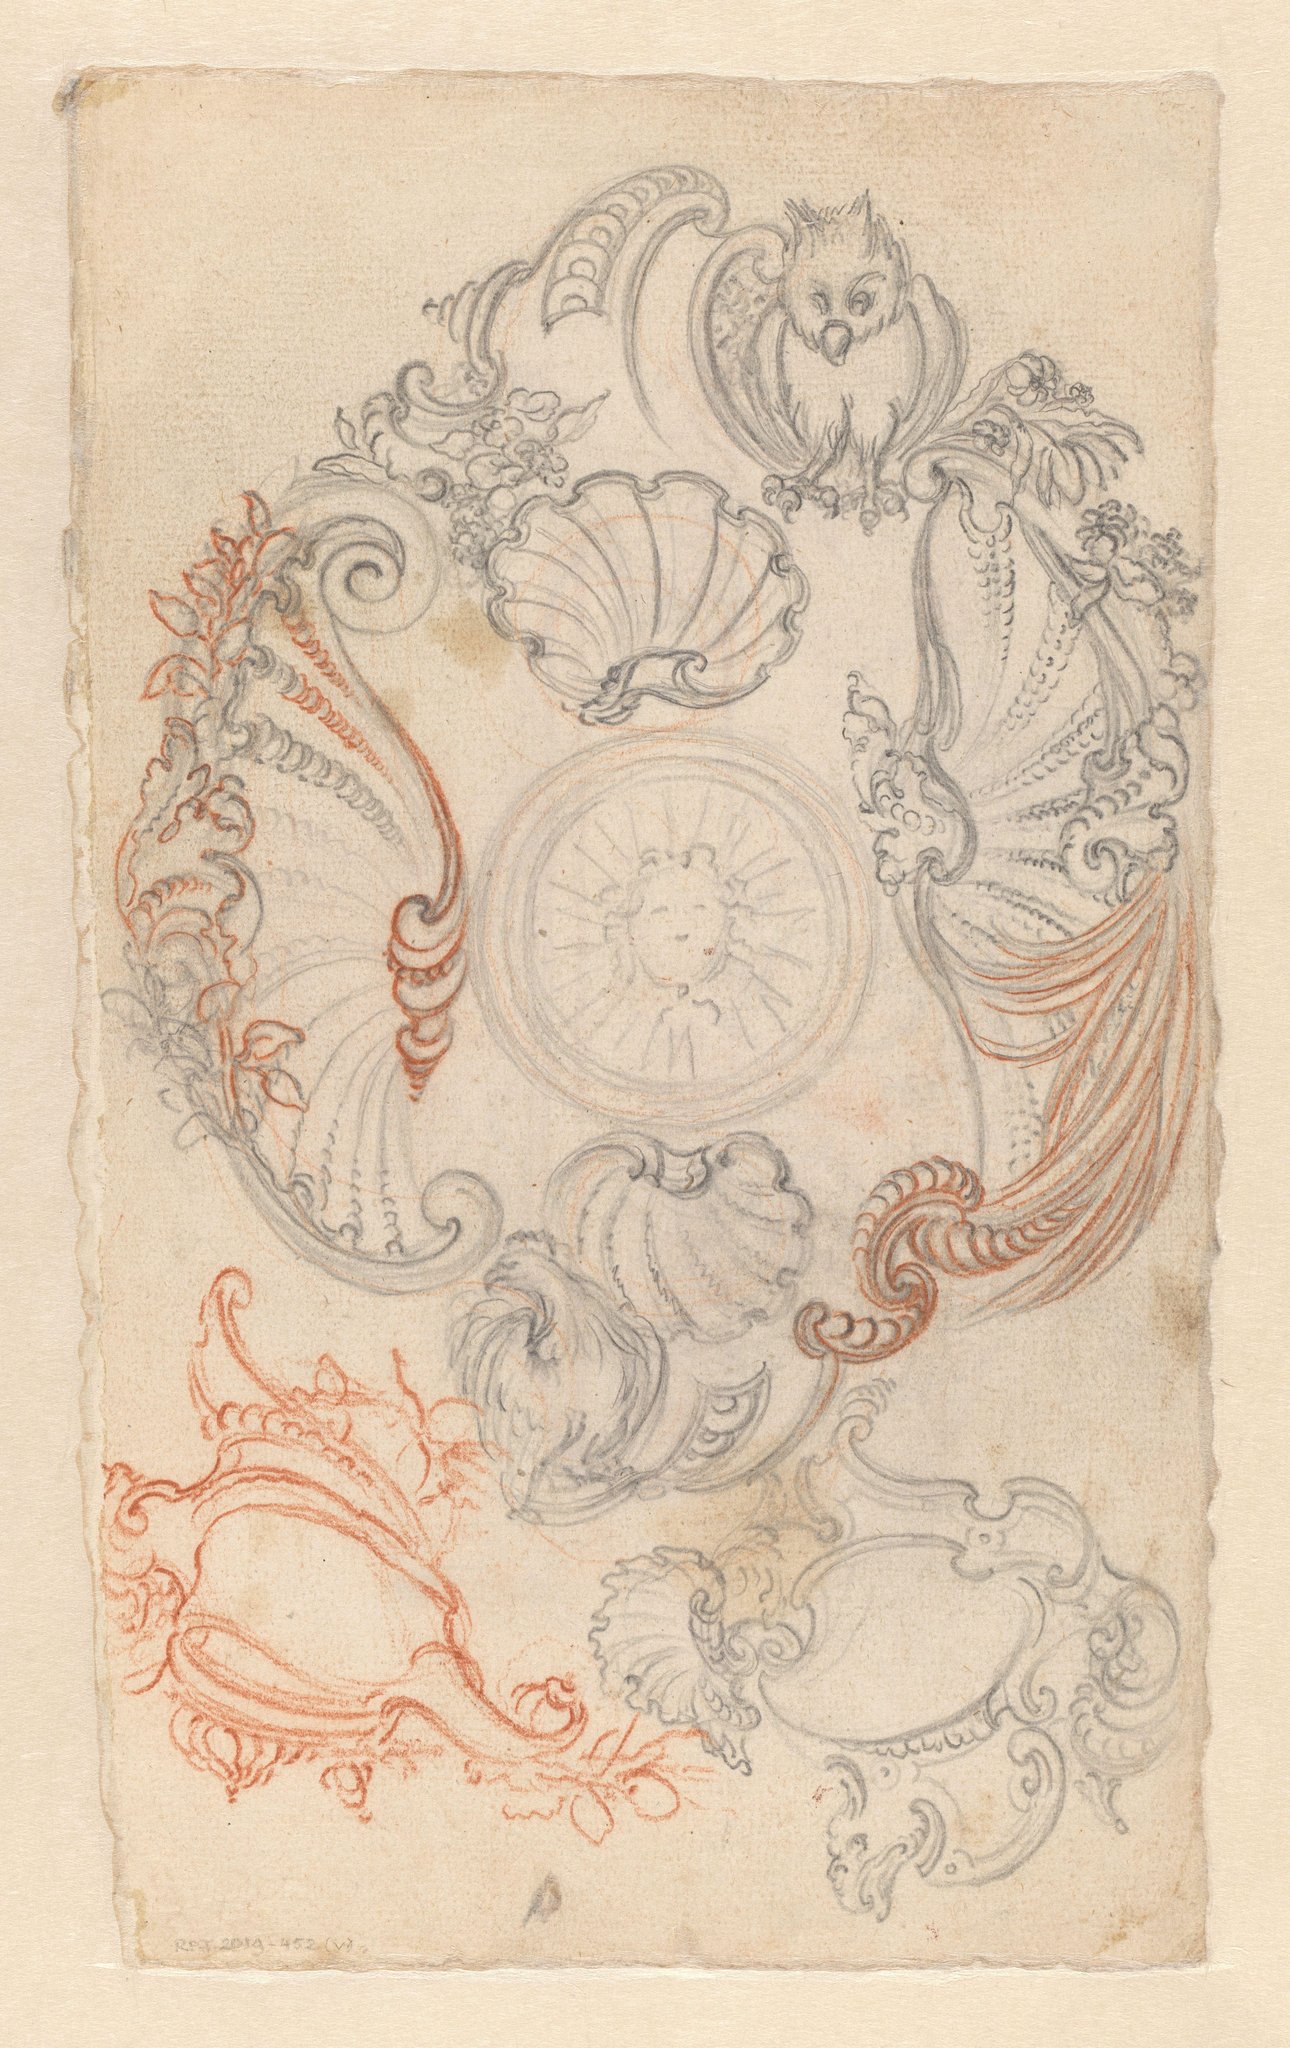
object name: design drawing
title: Ontwerp voor een terrine met cartouches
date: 1750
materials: chalk, graphite, paper